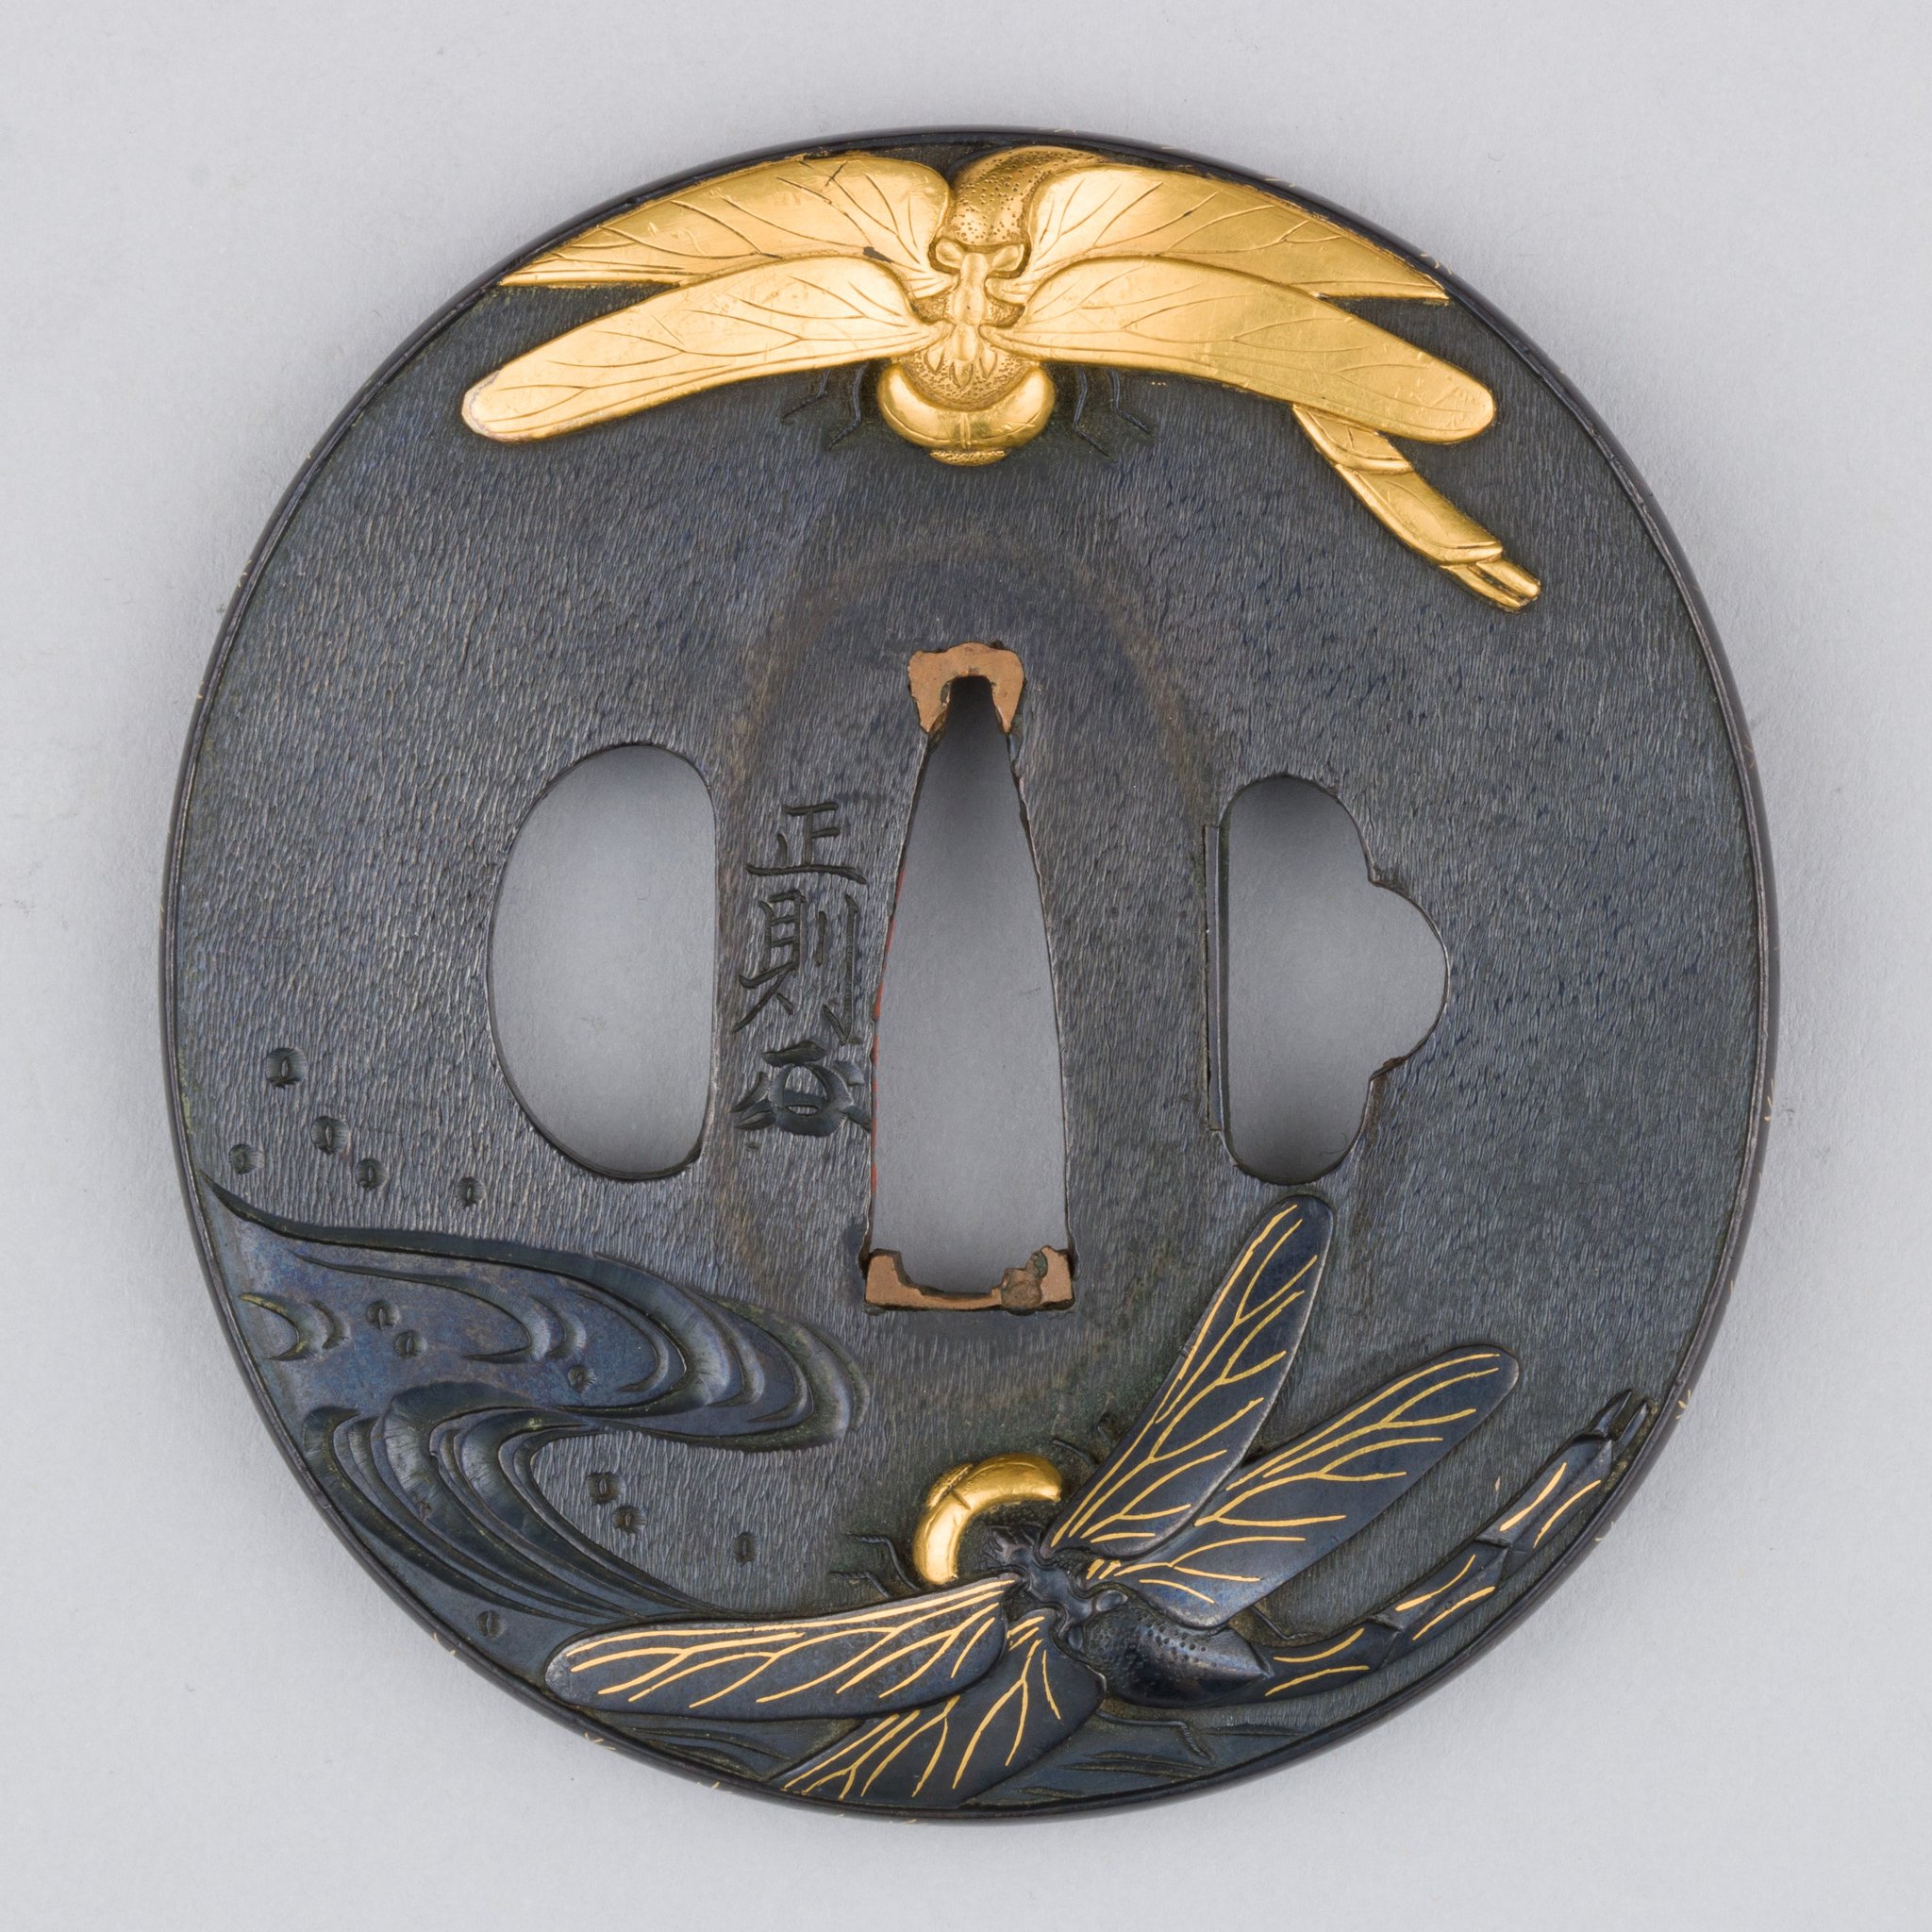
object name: sword guard tsuba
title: Sword Guard (Tsuba)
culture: japanese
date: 1701-1800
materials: copper, gold alloy, gold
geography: japan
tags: dragonflies